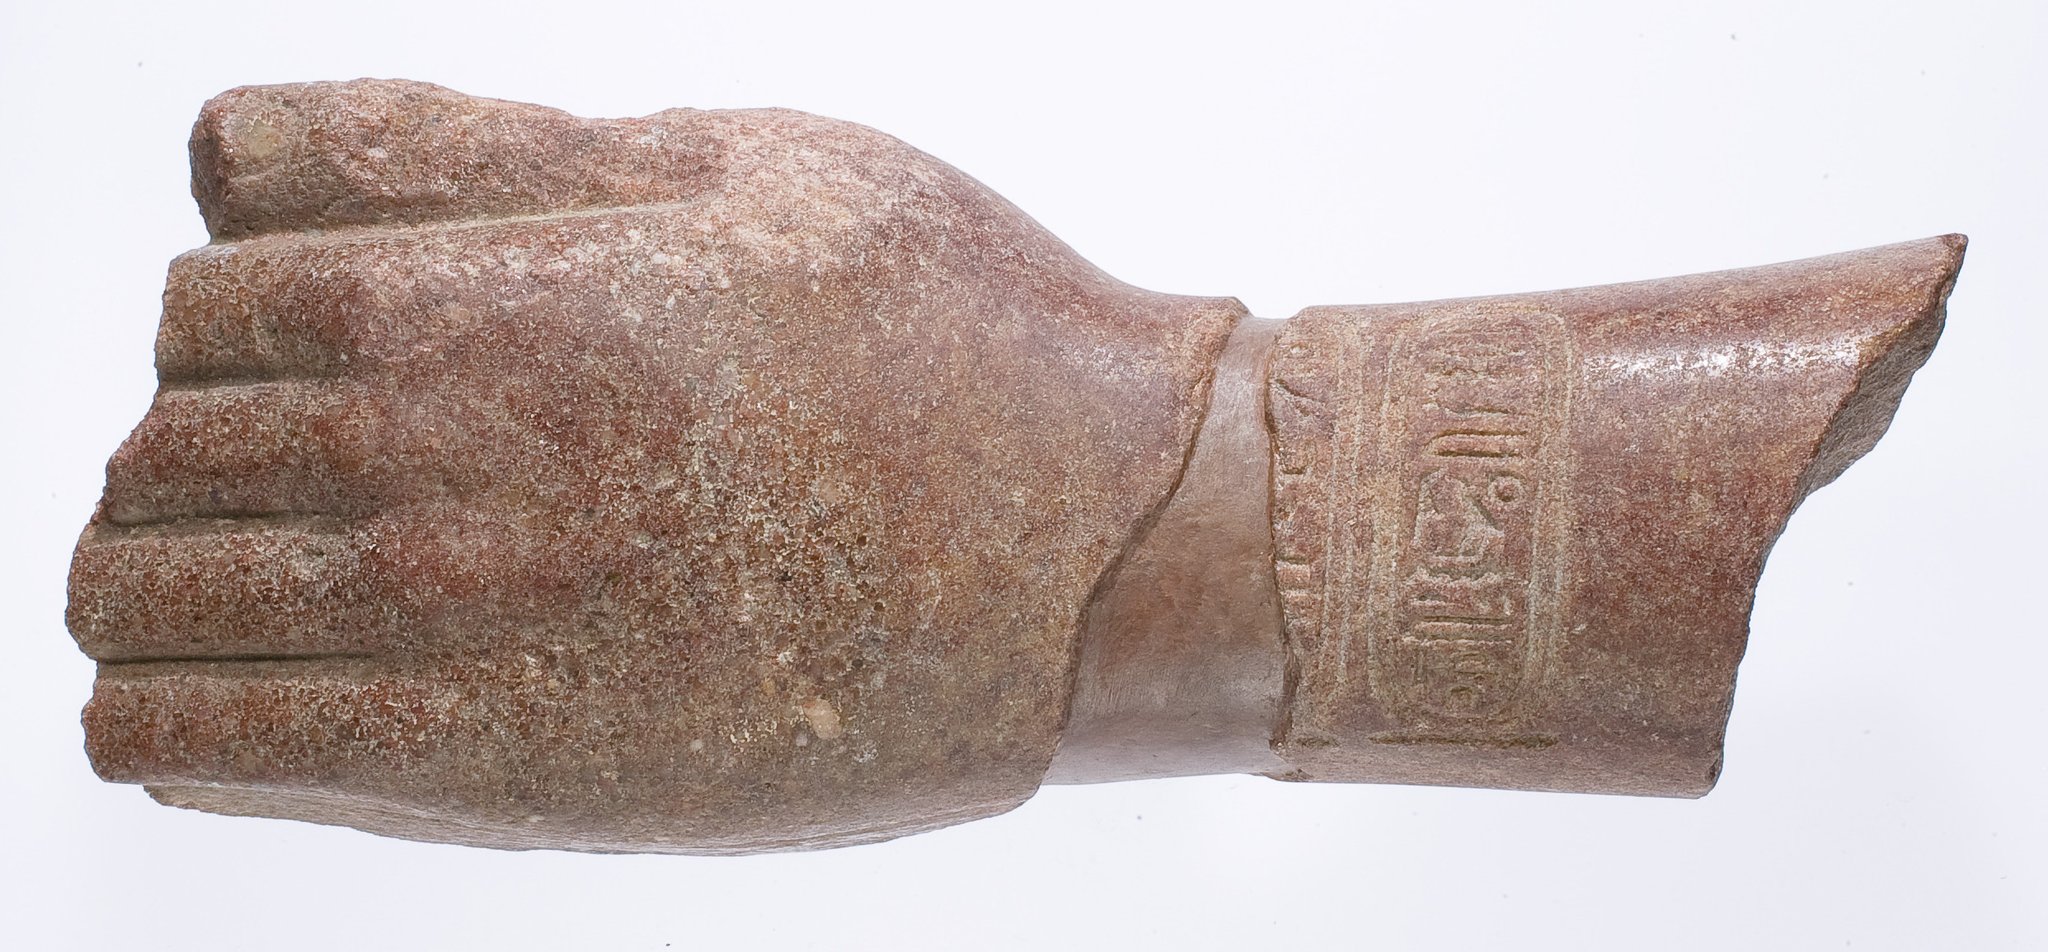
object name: left hand and arm, aten cartouch, stela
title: left hand and arm fragment with Aten cartouches from a statue supporting a stela?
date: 1353-1336 BCE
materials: quartzite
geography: egypt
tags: hands